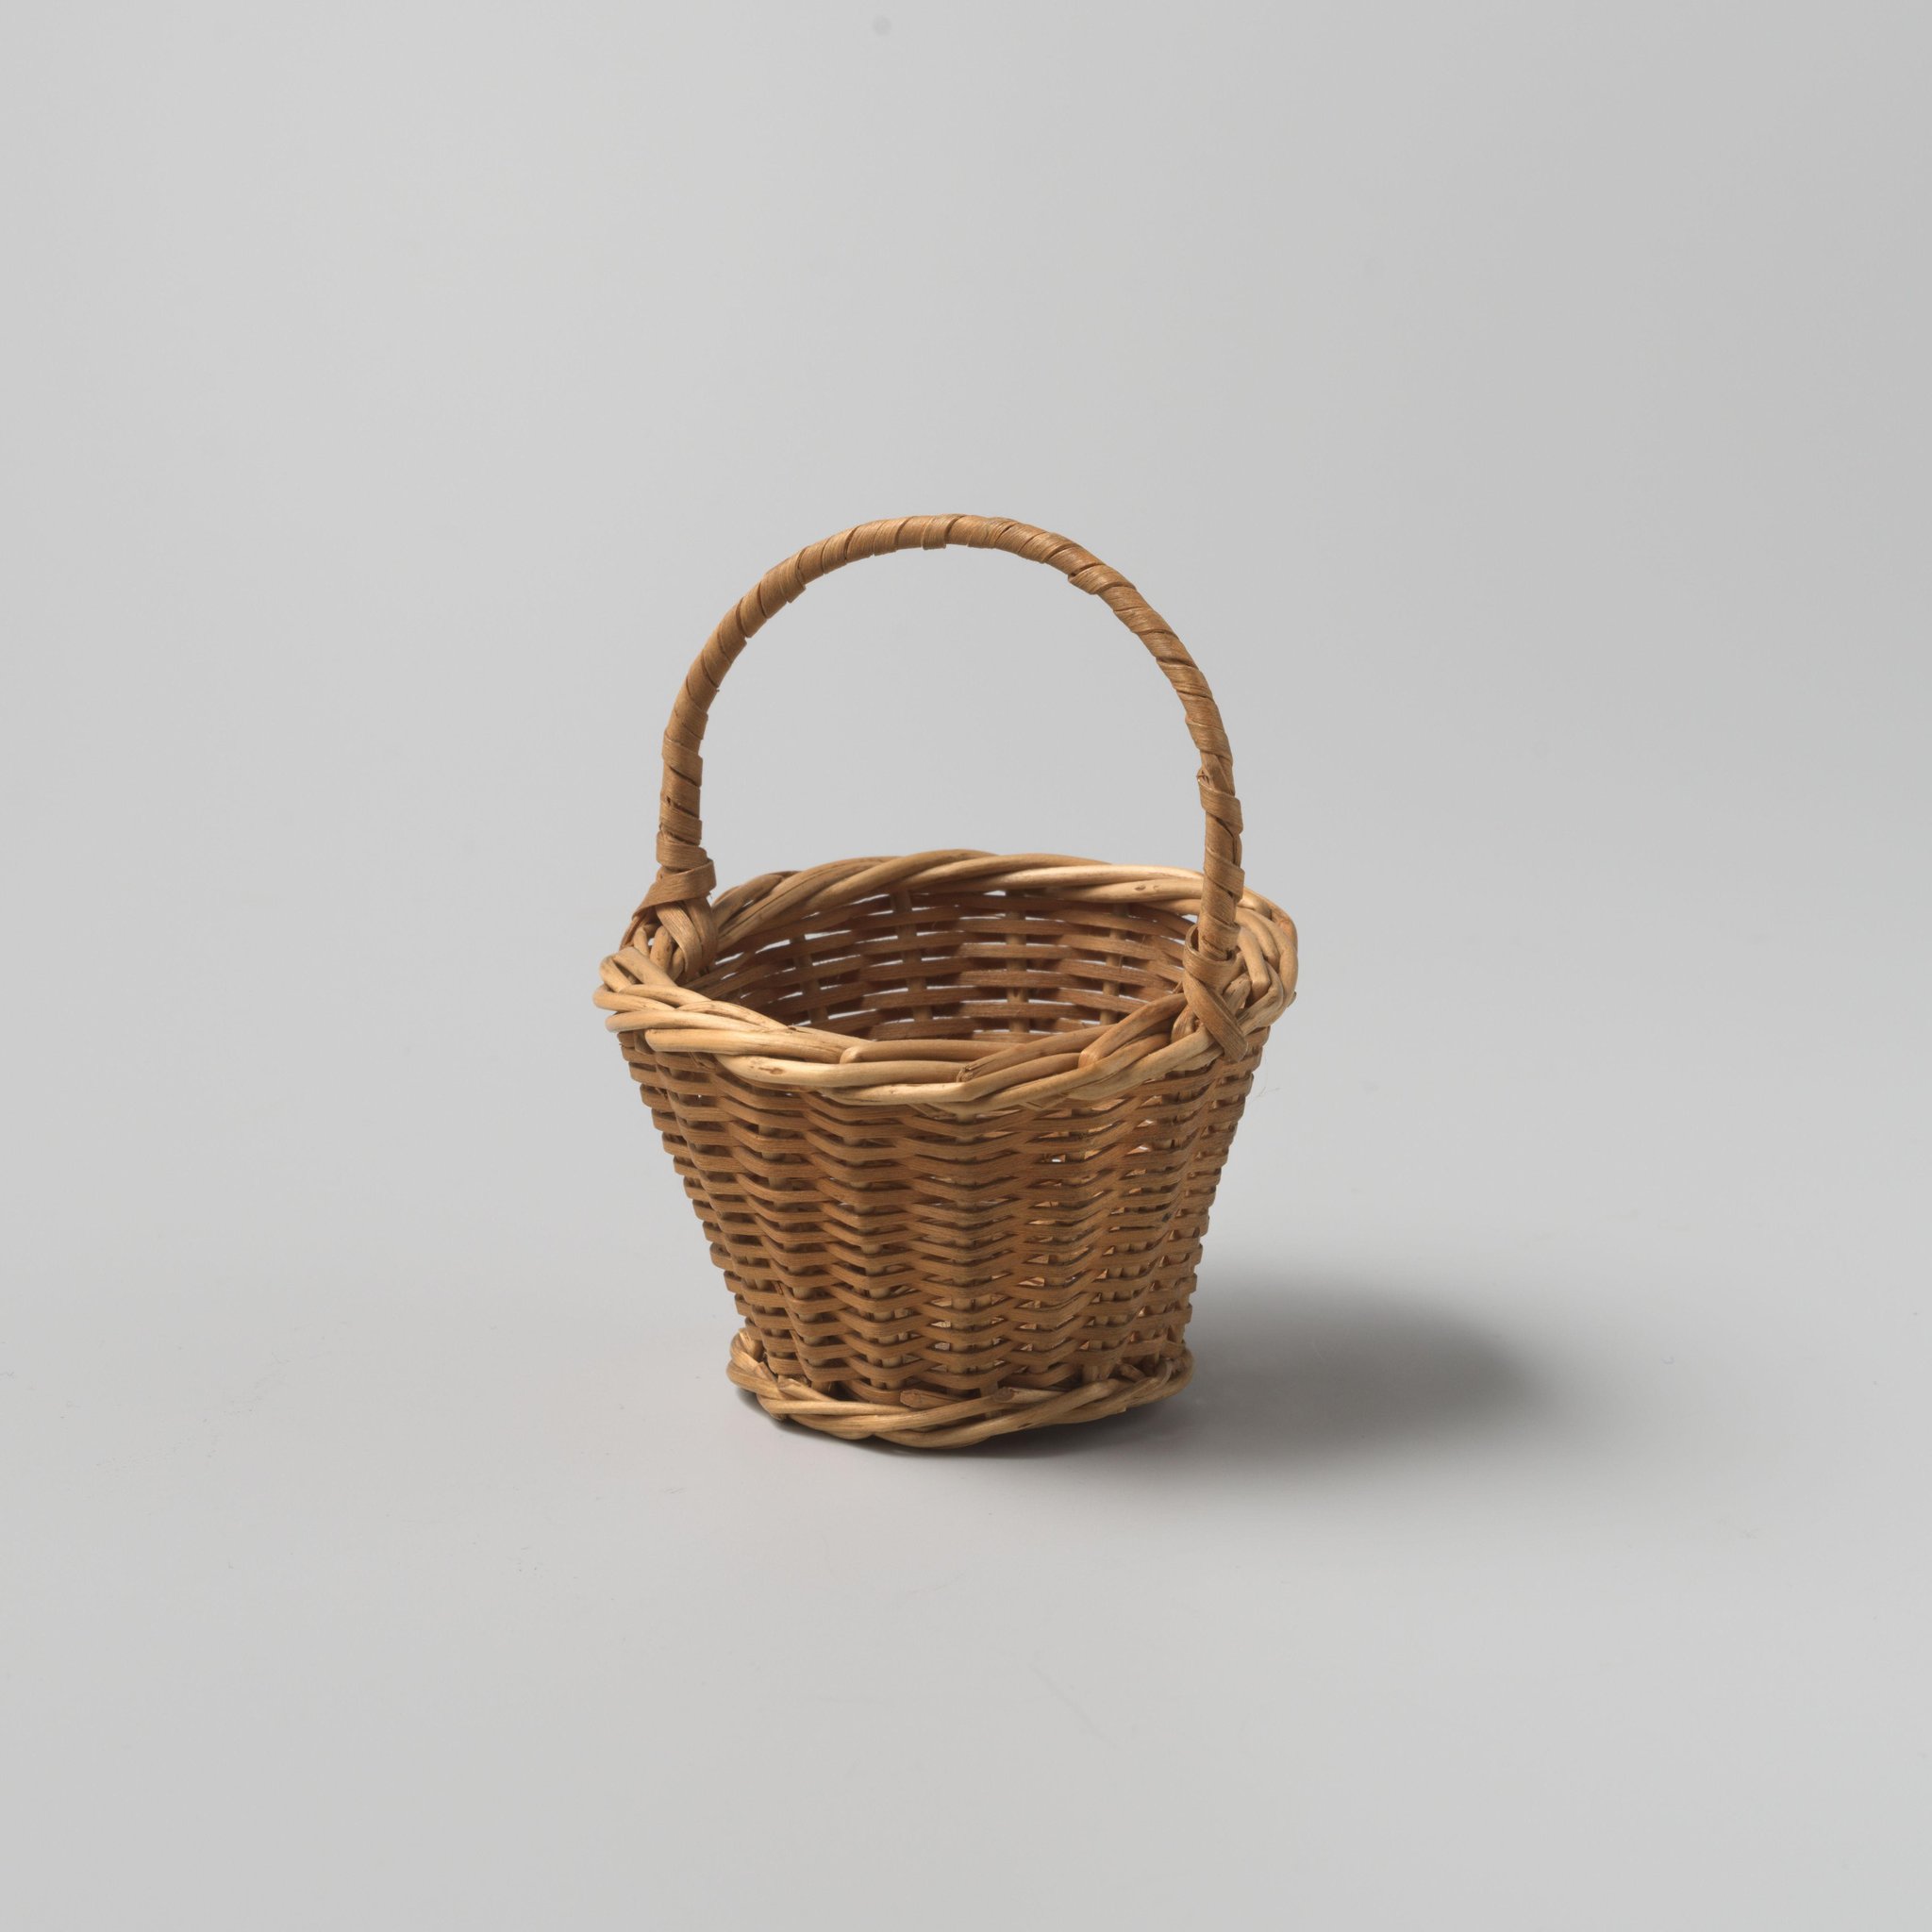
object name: ring basket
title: Hengselmand vervaardigd van ronde en gespleten wilgenteen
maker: Anonymous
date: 1676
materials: plant material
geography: halle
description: Hengselmand, vervaardigd van ronde en gespleten wilgenteen.